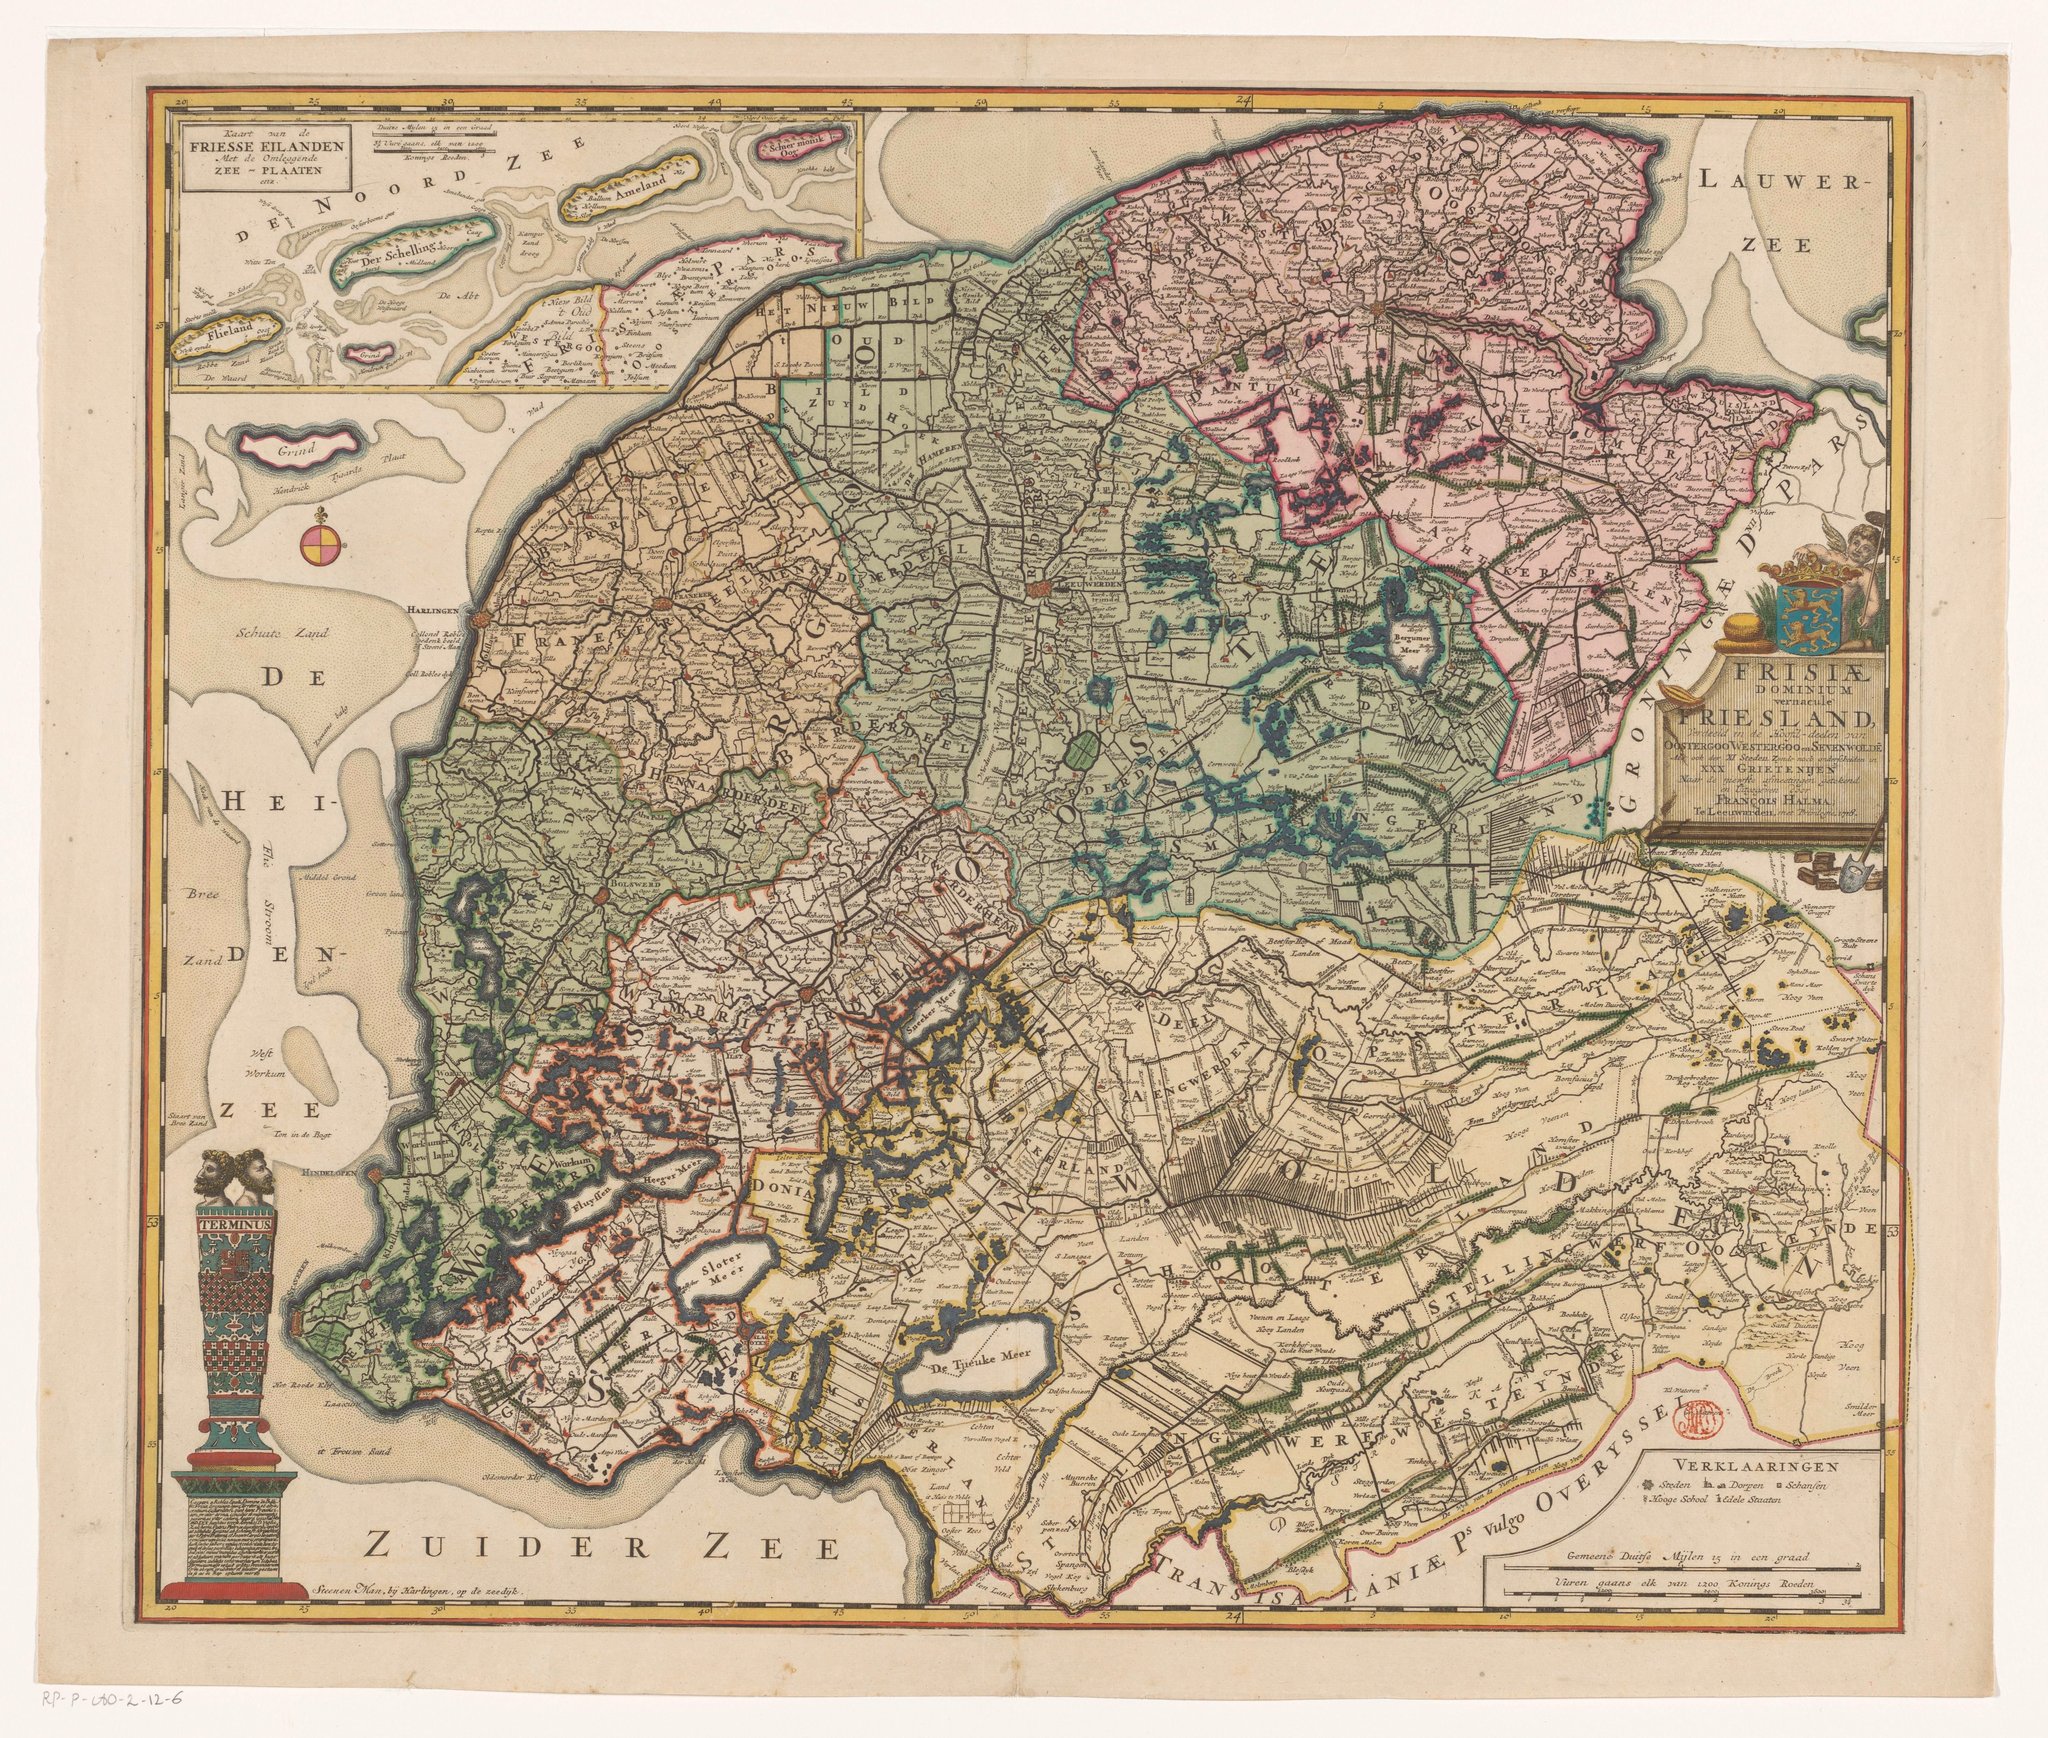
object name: map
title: Kaart van Friesland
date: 1718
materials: paper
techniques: engraving, etching, hand coloring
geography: leeuwarden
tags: coat of arms (as symbol of the state, etc.), maps of separate countries or regions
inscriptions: collector's mark: Lugt 195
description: Linksboven inzetkaart van Vlieland, Terschelling, Ameland en Schiermonnikoog, met twee schaalstokken: Duitze mijlen 15 in een graad, 3.25 uure gaans elk van 1200 konings roeden. Linksonder afbeelding van het standbeeld de Stenen Man te Harlingen. Rechtsmidden titelcartouche met daarboven het wapen van Friesland. Rechtsonder legenda en twee schaalstokken: Gemeene Duitse mijlen 15 in een graad, Uuren gaans elk van 1200 konings roeden. Gradenverdeling langs de randen.